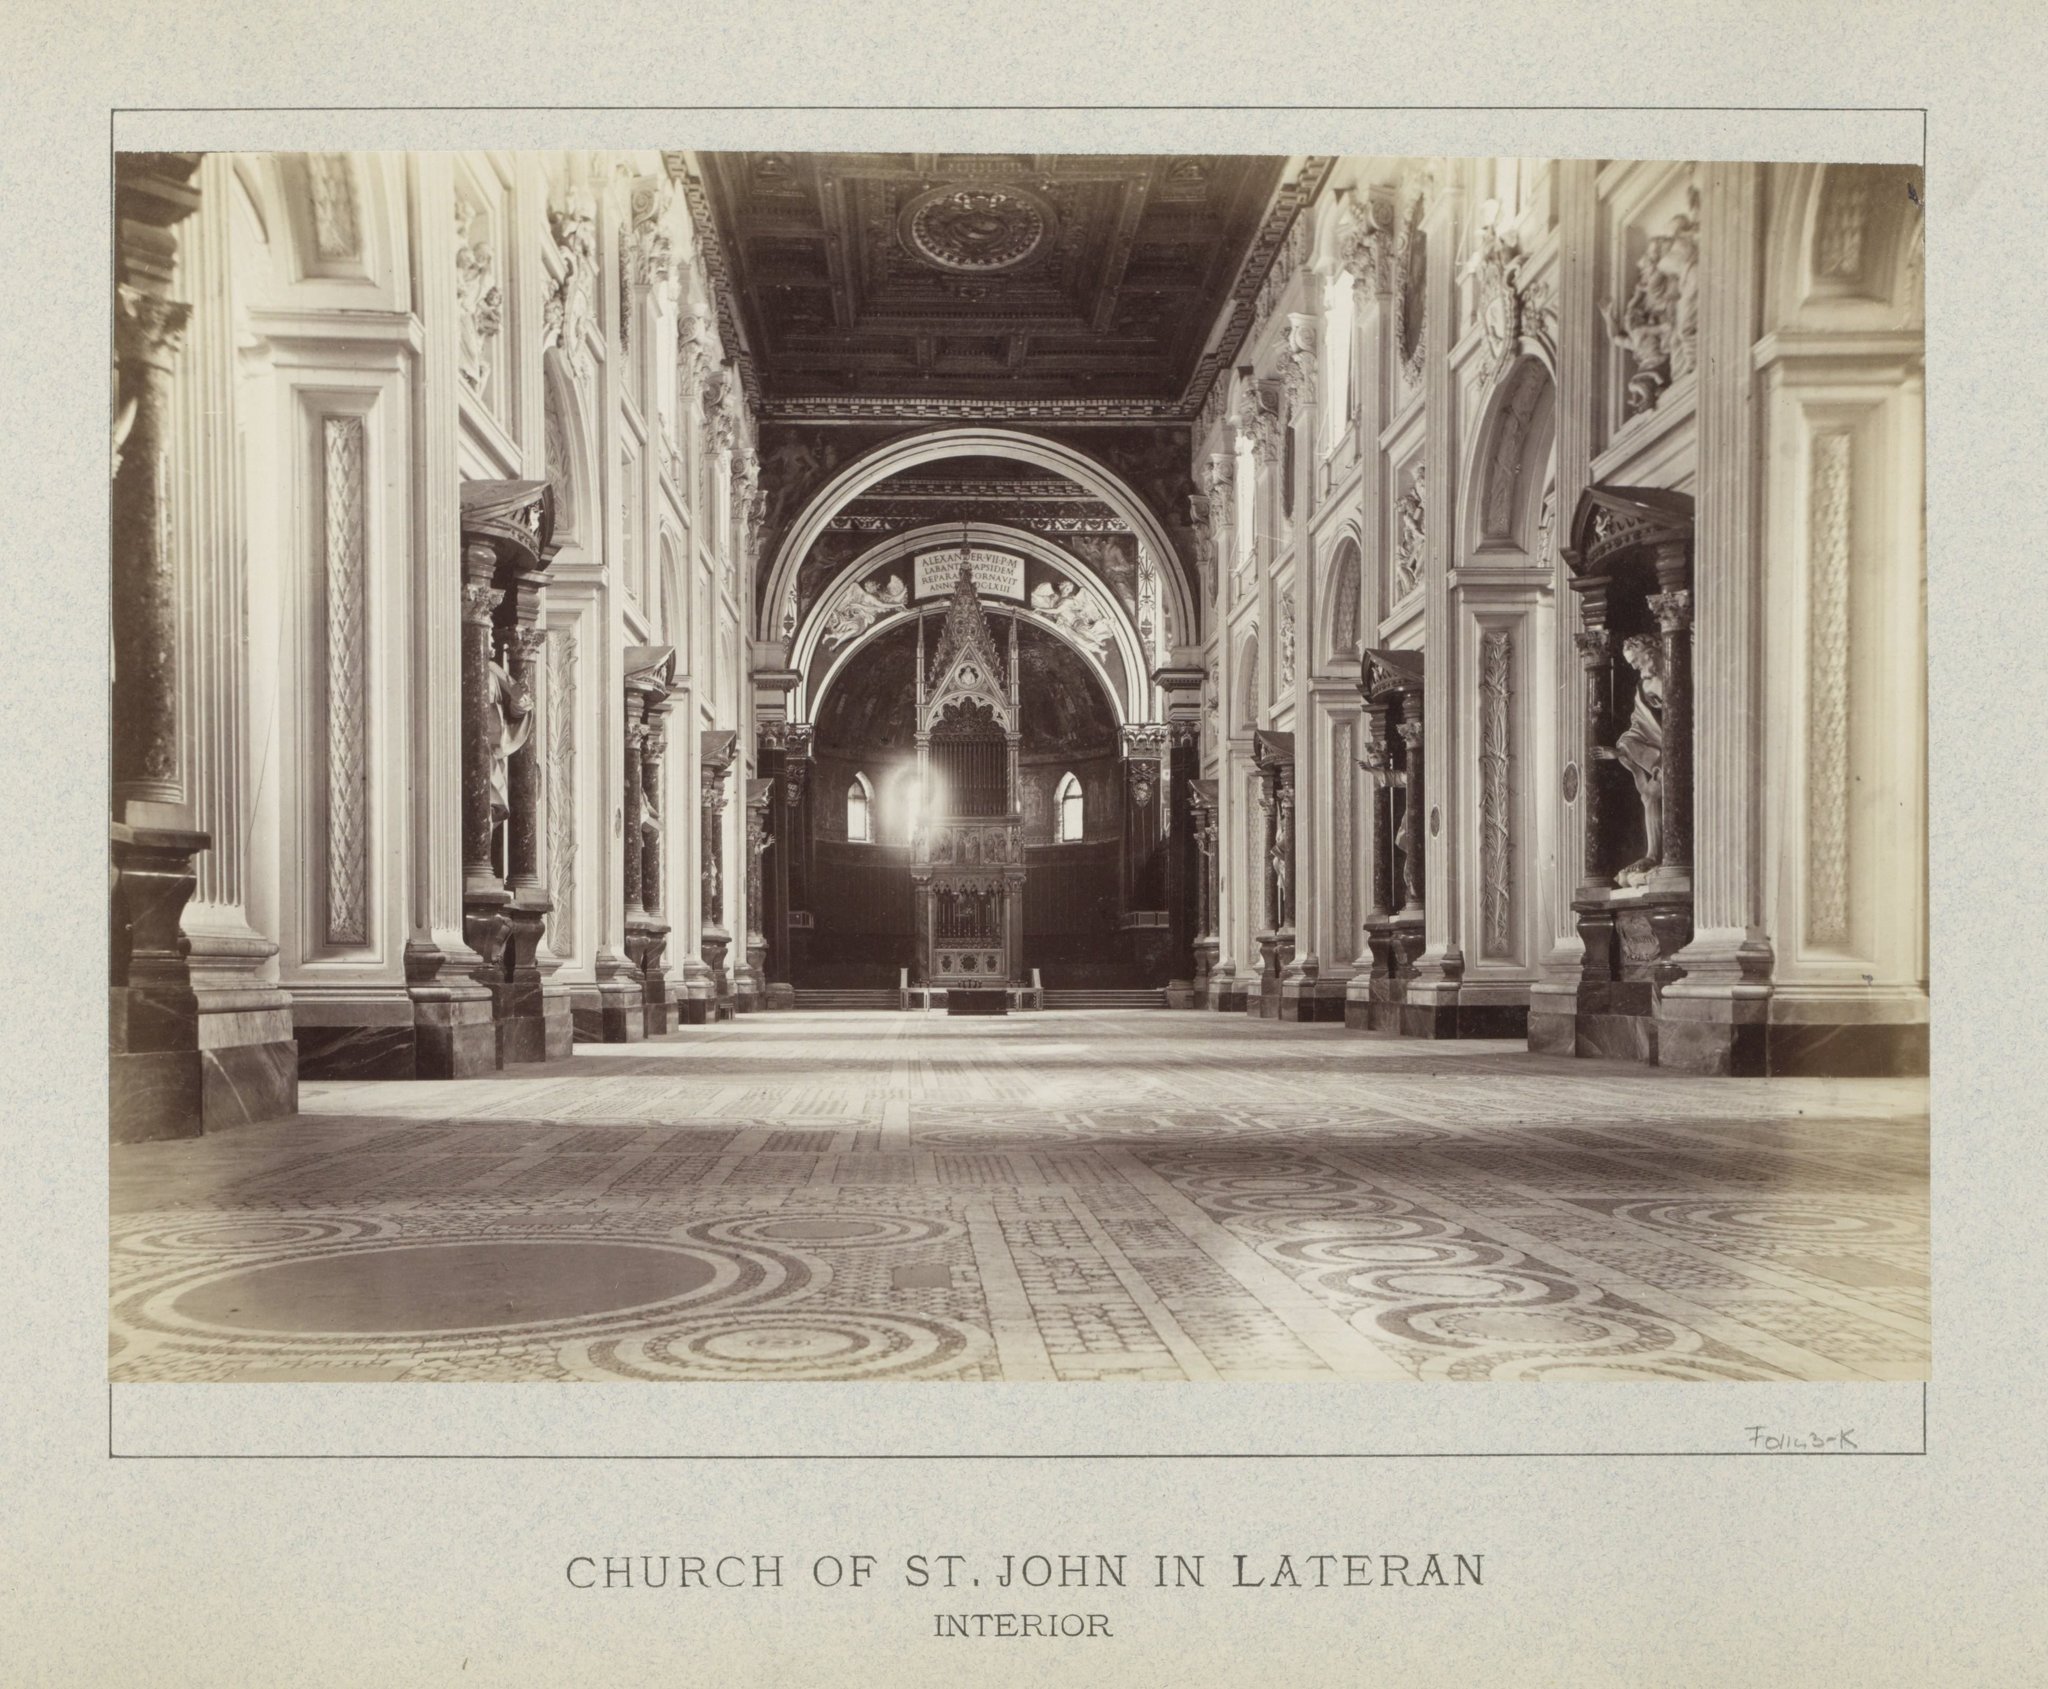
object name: photograph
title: Interieur van de Sint-Jan van Lateranen gezien richting baldakijn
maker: Anonymous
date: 1860-1900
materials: photographic support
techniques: albumen print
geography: sint-jan van lateranen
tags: canopy, baldachin, interior of church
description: Onderdeel van Fotoalbum met opnames van bezienswaardigheden en kunstwerken in Rome.